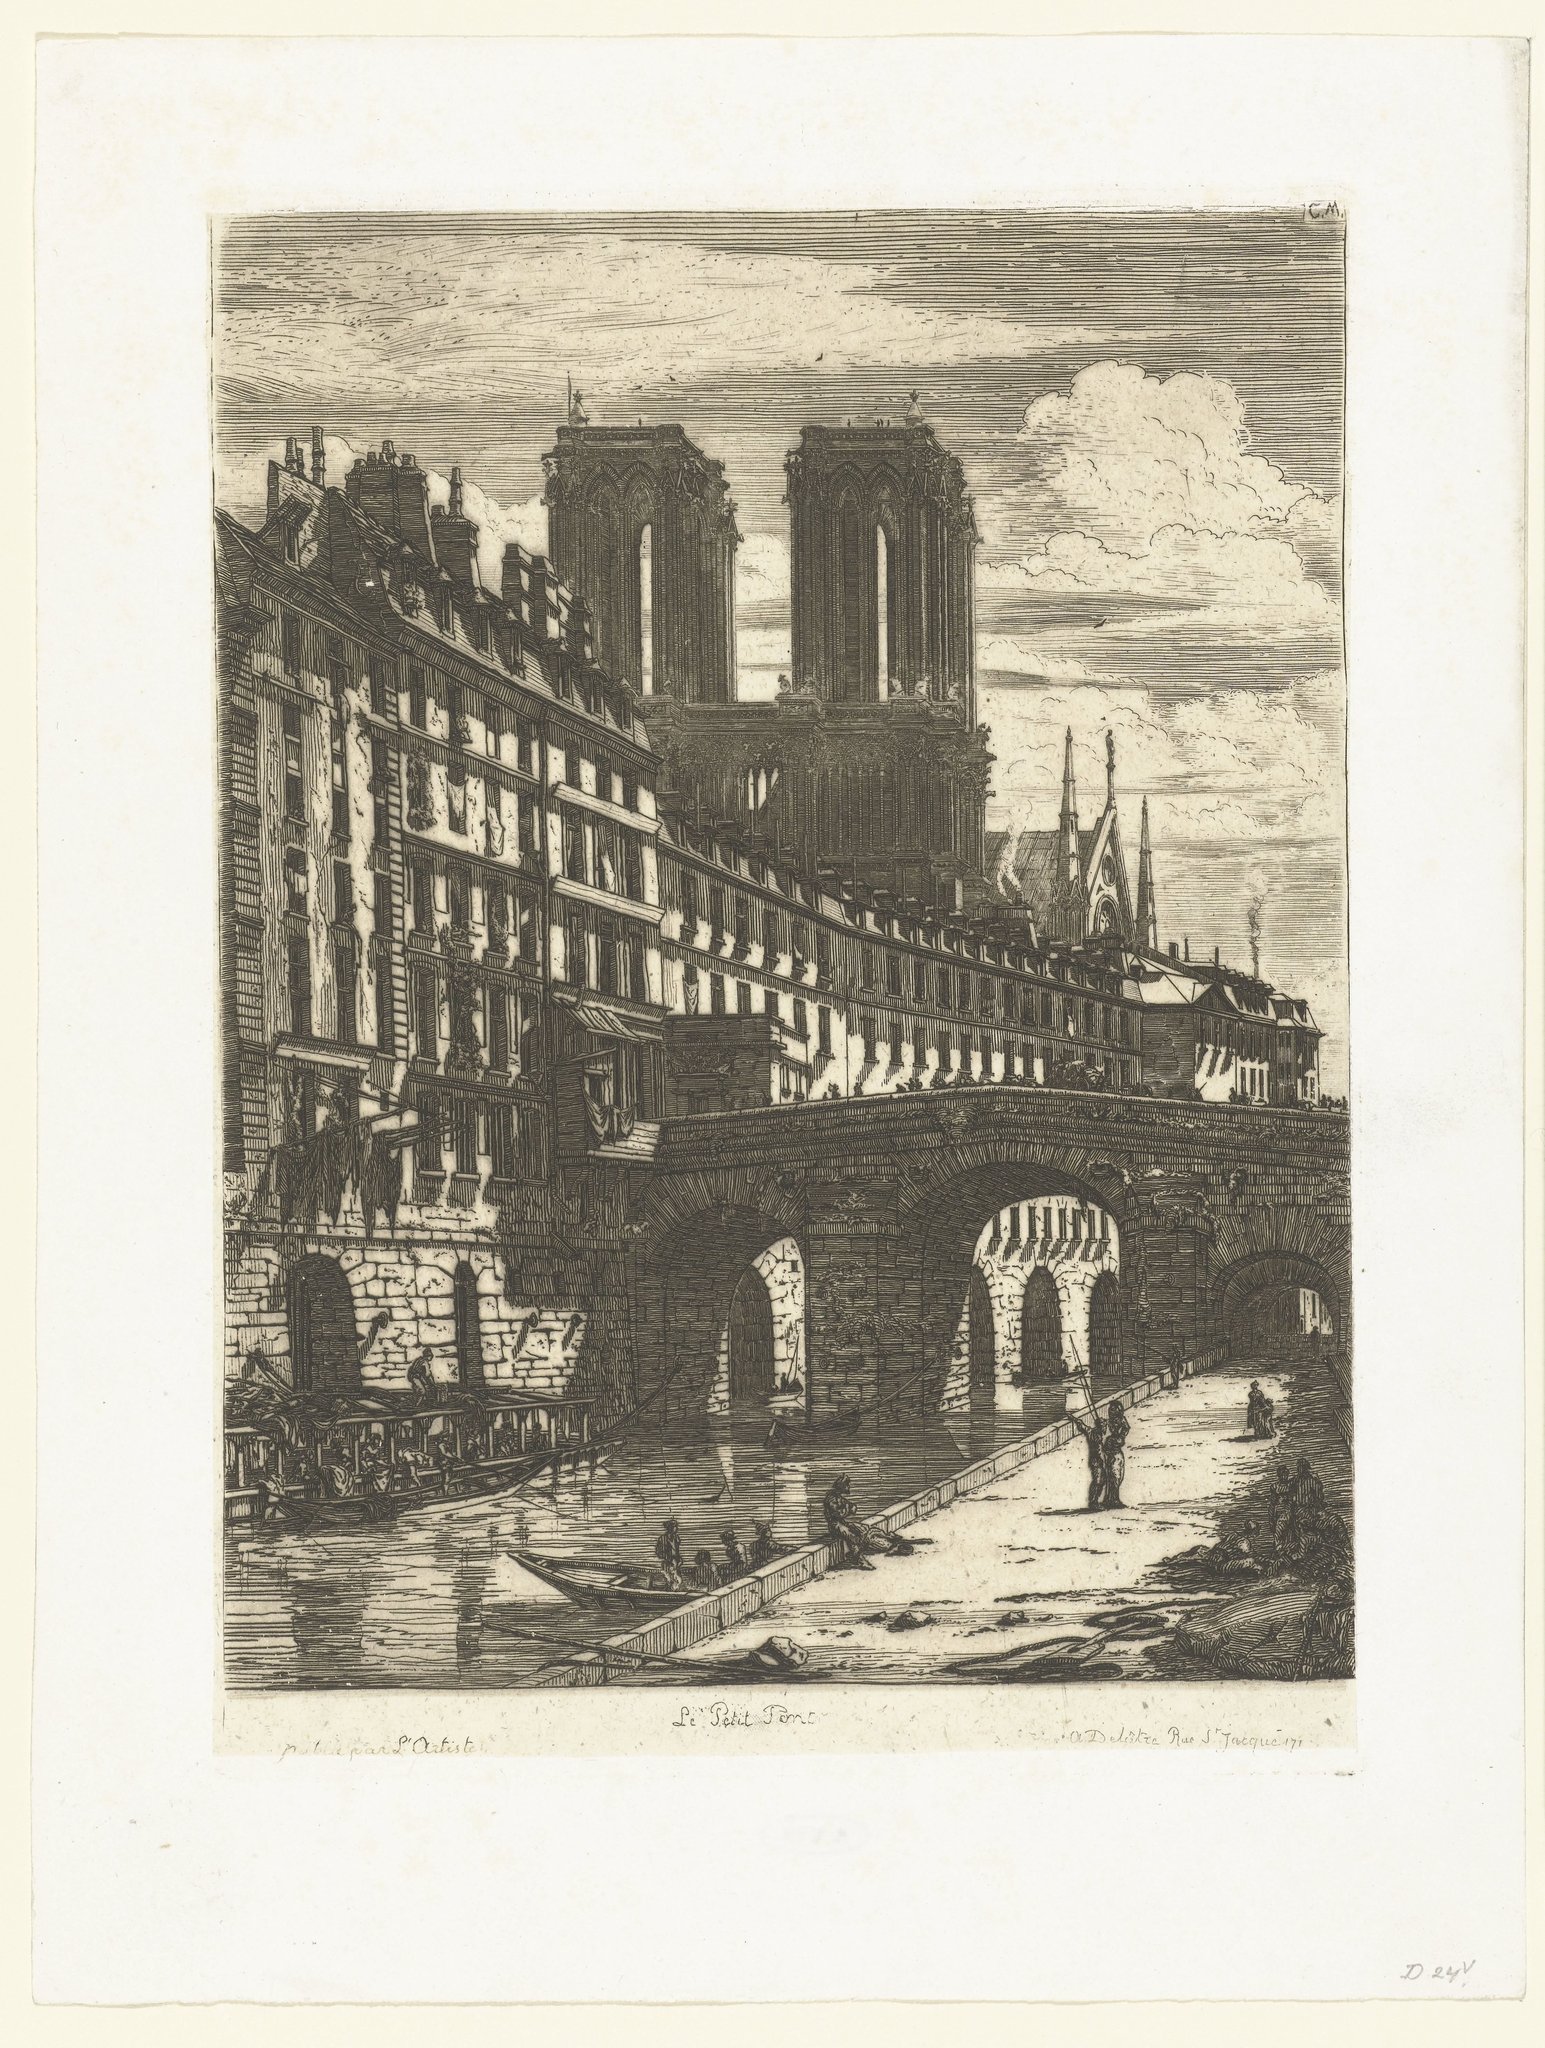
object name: print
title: Le petit pont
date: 1850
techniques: printmaking, engraving, etching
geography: paris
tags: city-view in general; 'veduta'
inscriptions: collector's mark: Lugt 2228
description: De brug Petit Pont over de Seine gezien vanaf het Ile de la Cité. Op de linkeroever aan de Quai de Marché Neuf staat het Hôtel Dieu en de torens van de Notre Dame steken boven de daken uit.